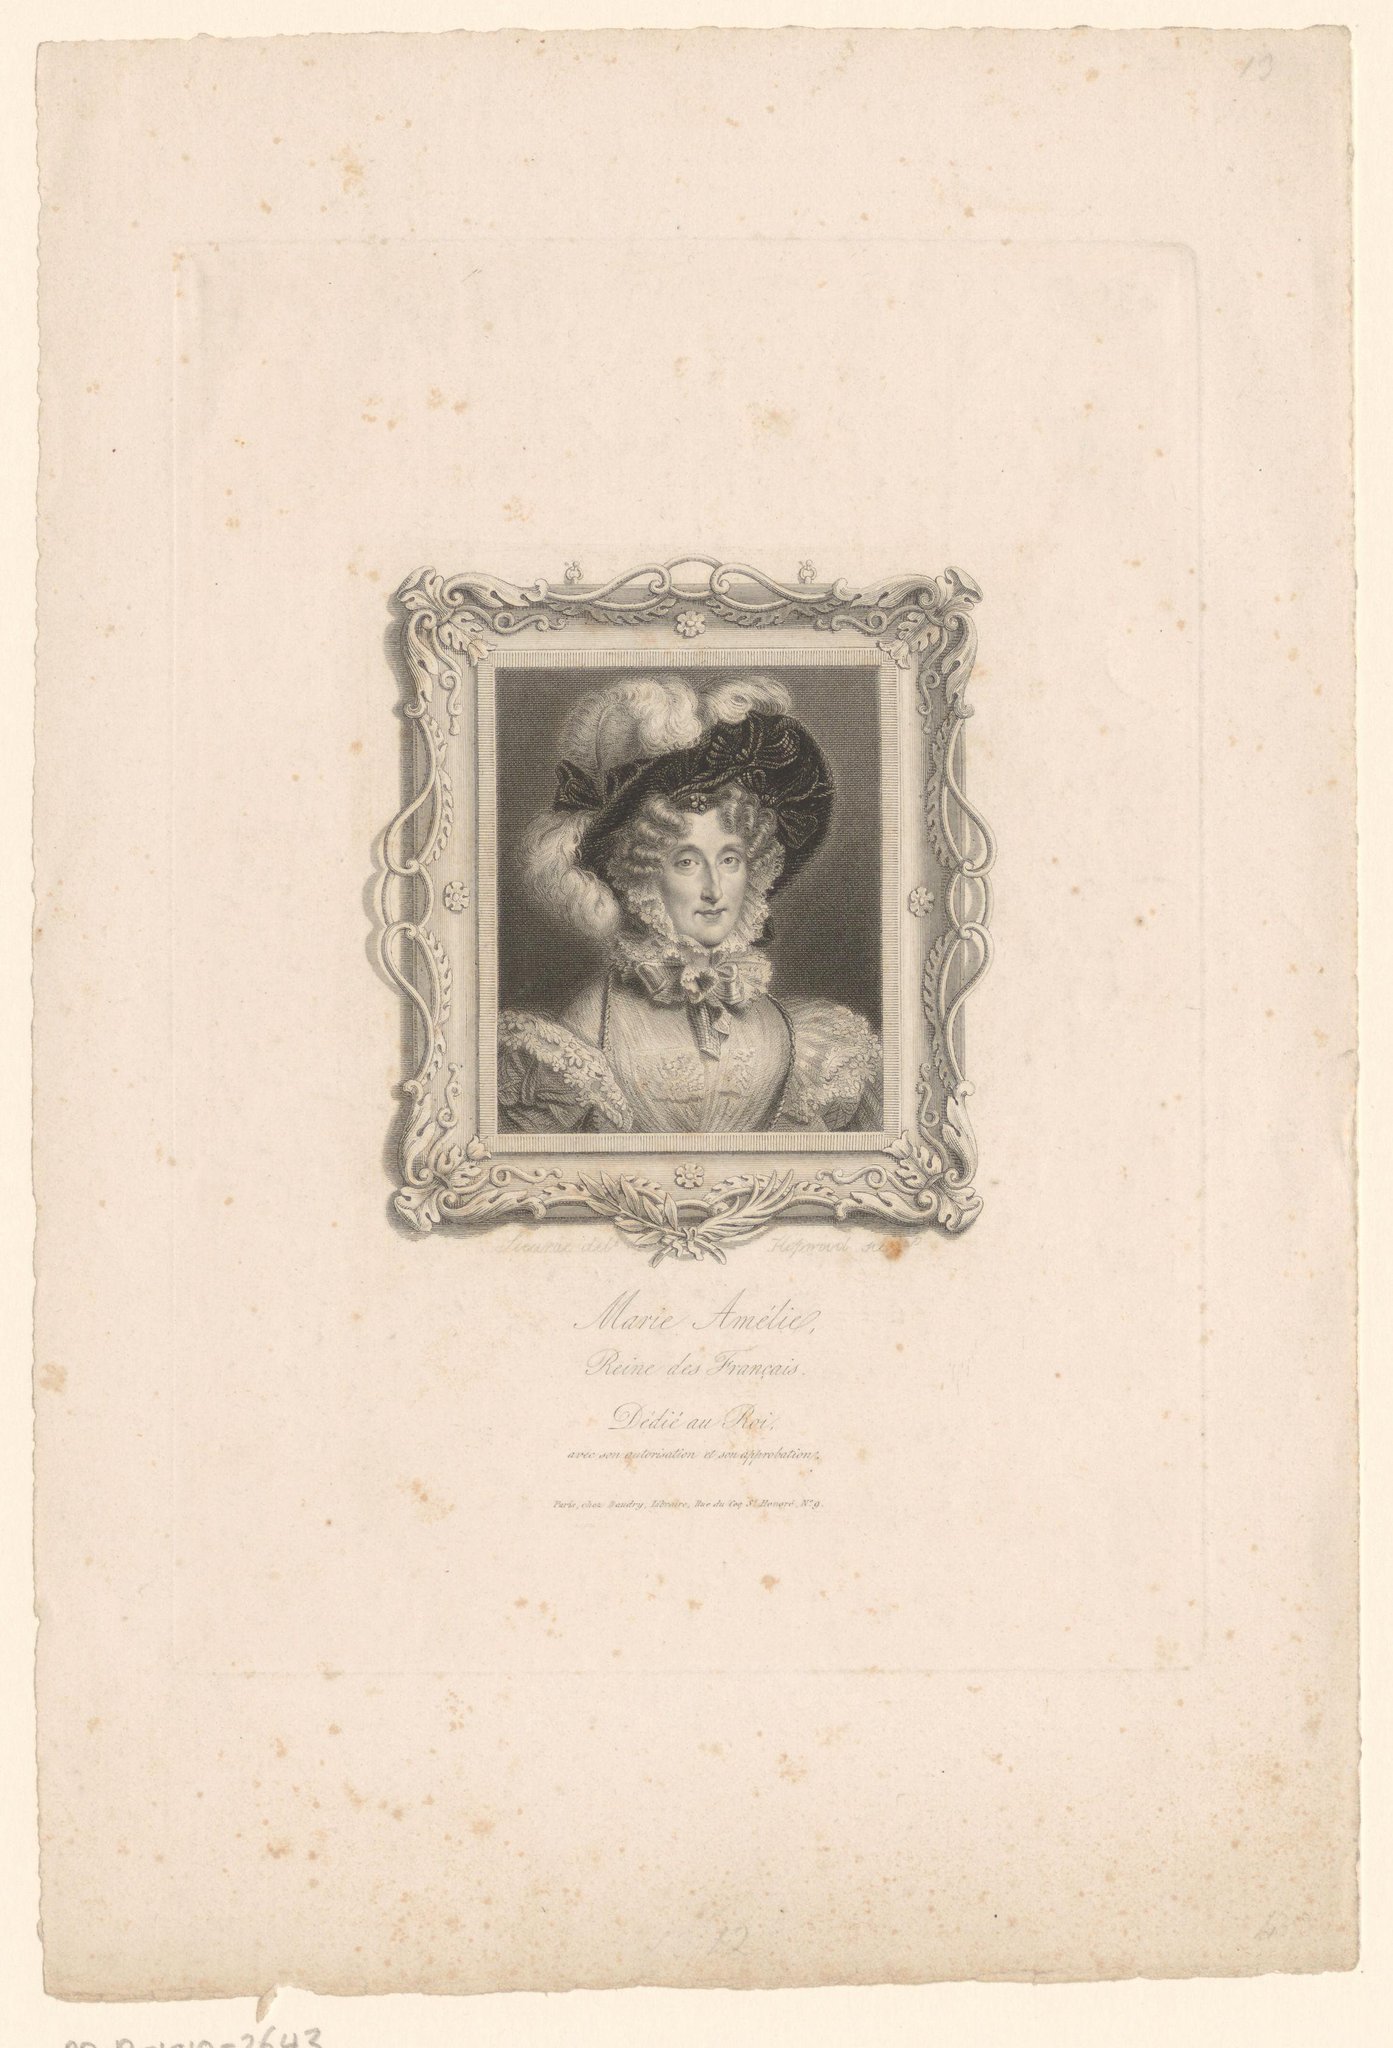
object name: print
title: Marie Amélie, Reine des Français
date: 1830-1848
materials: paper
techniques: etching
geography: paris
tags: caserta, london, historical persons - bb - woman, queen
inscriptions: collector's mark: Lugt 2228